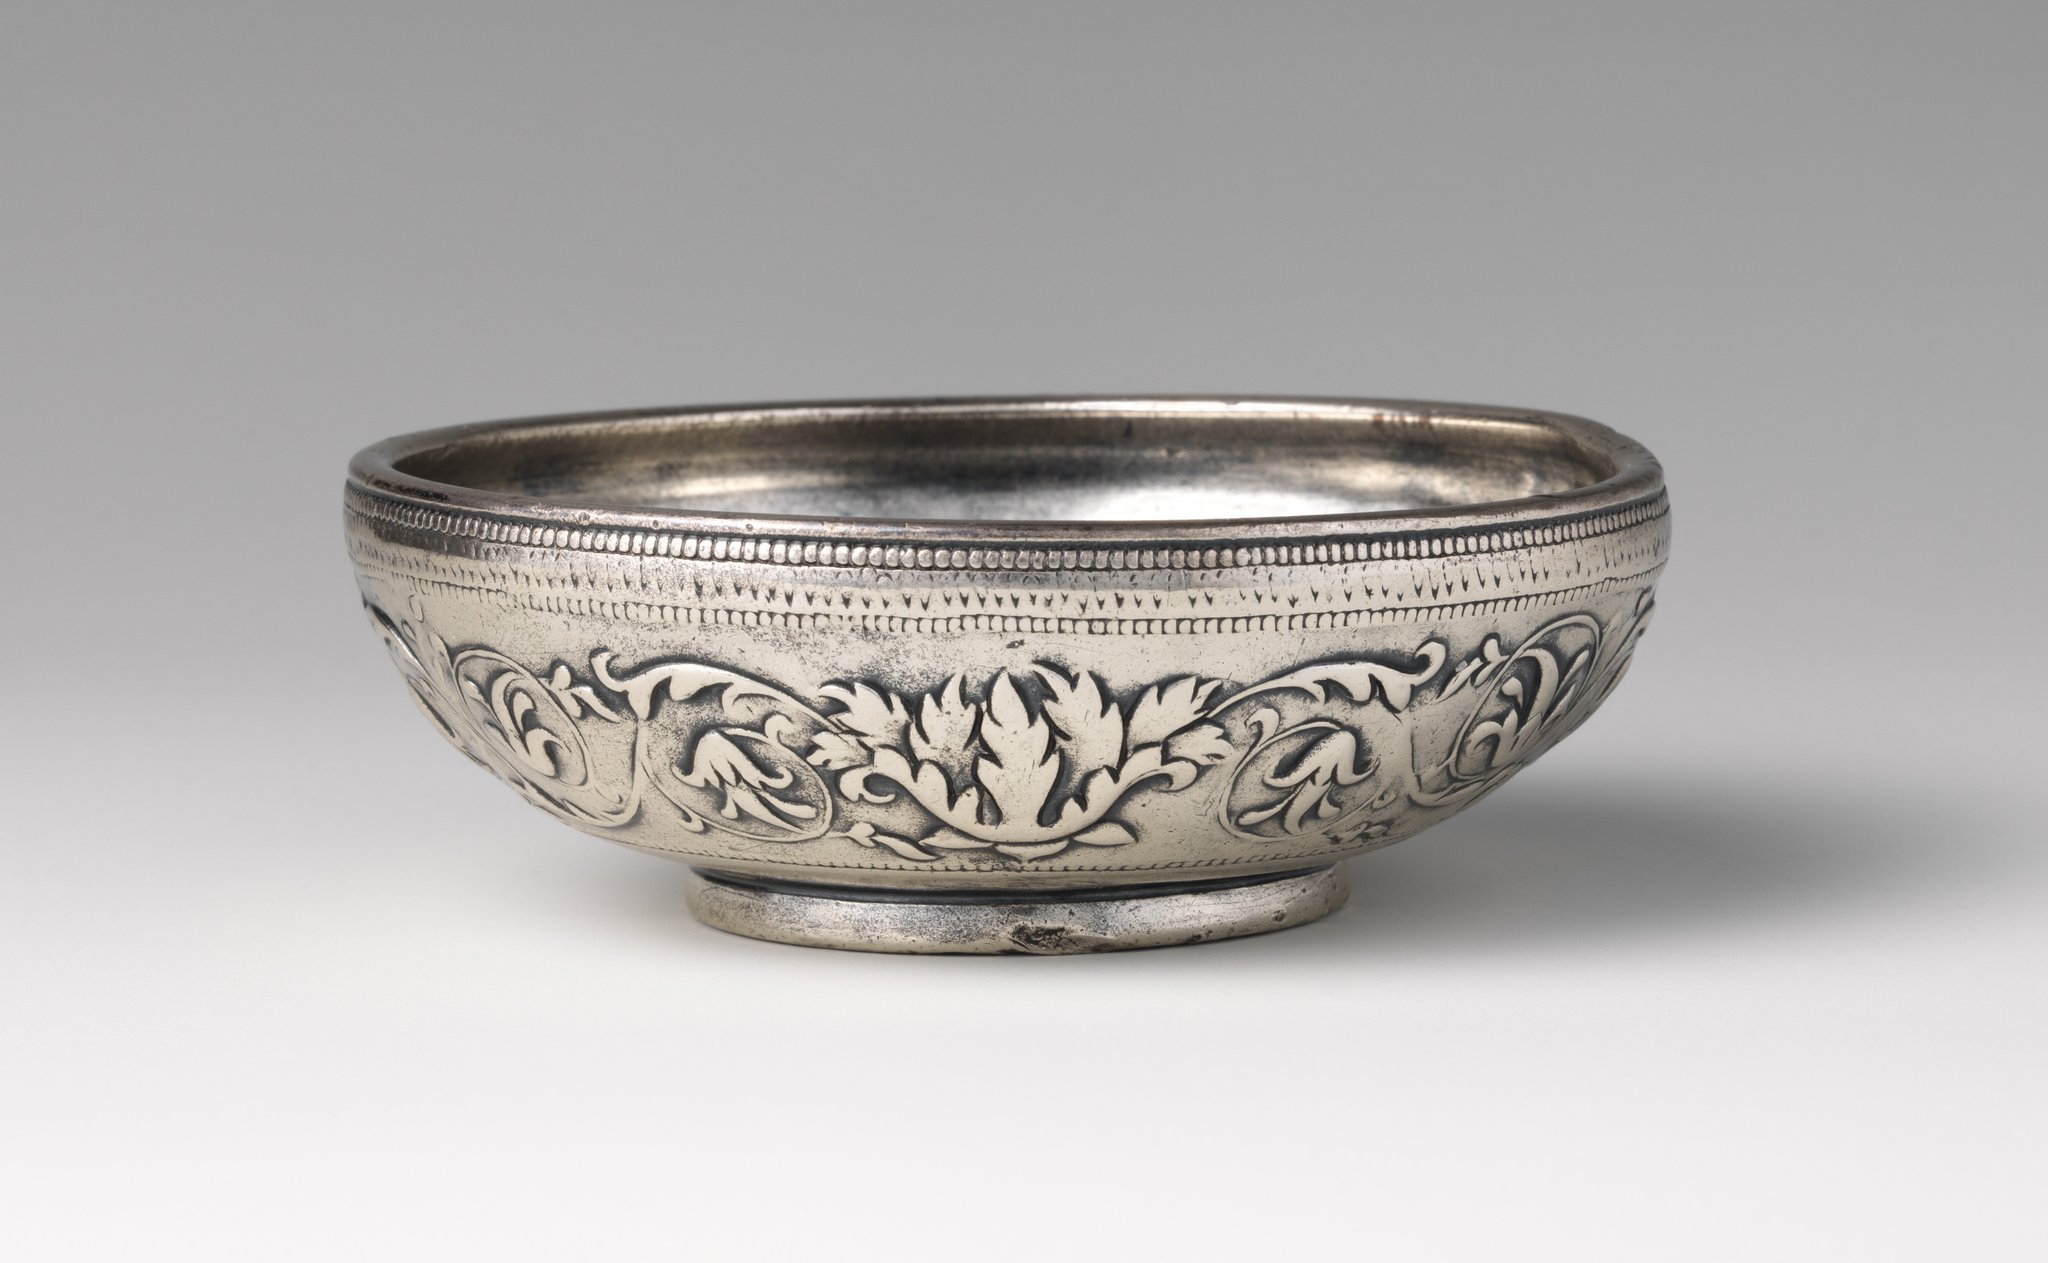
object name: bowl with graffito, carus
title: Silver bowl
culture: roman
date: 200-250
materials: silver